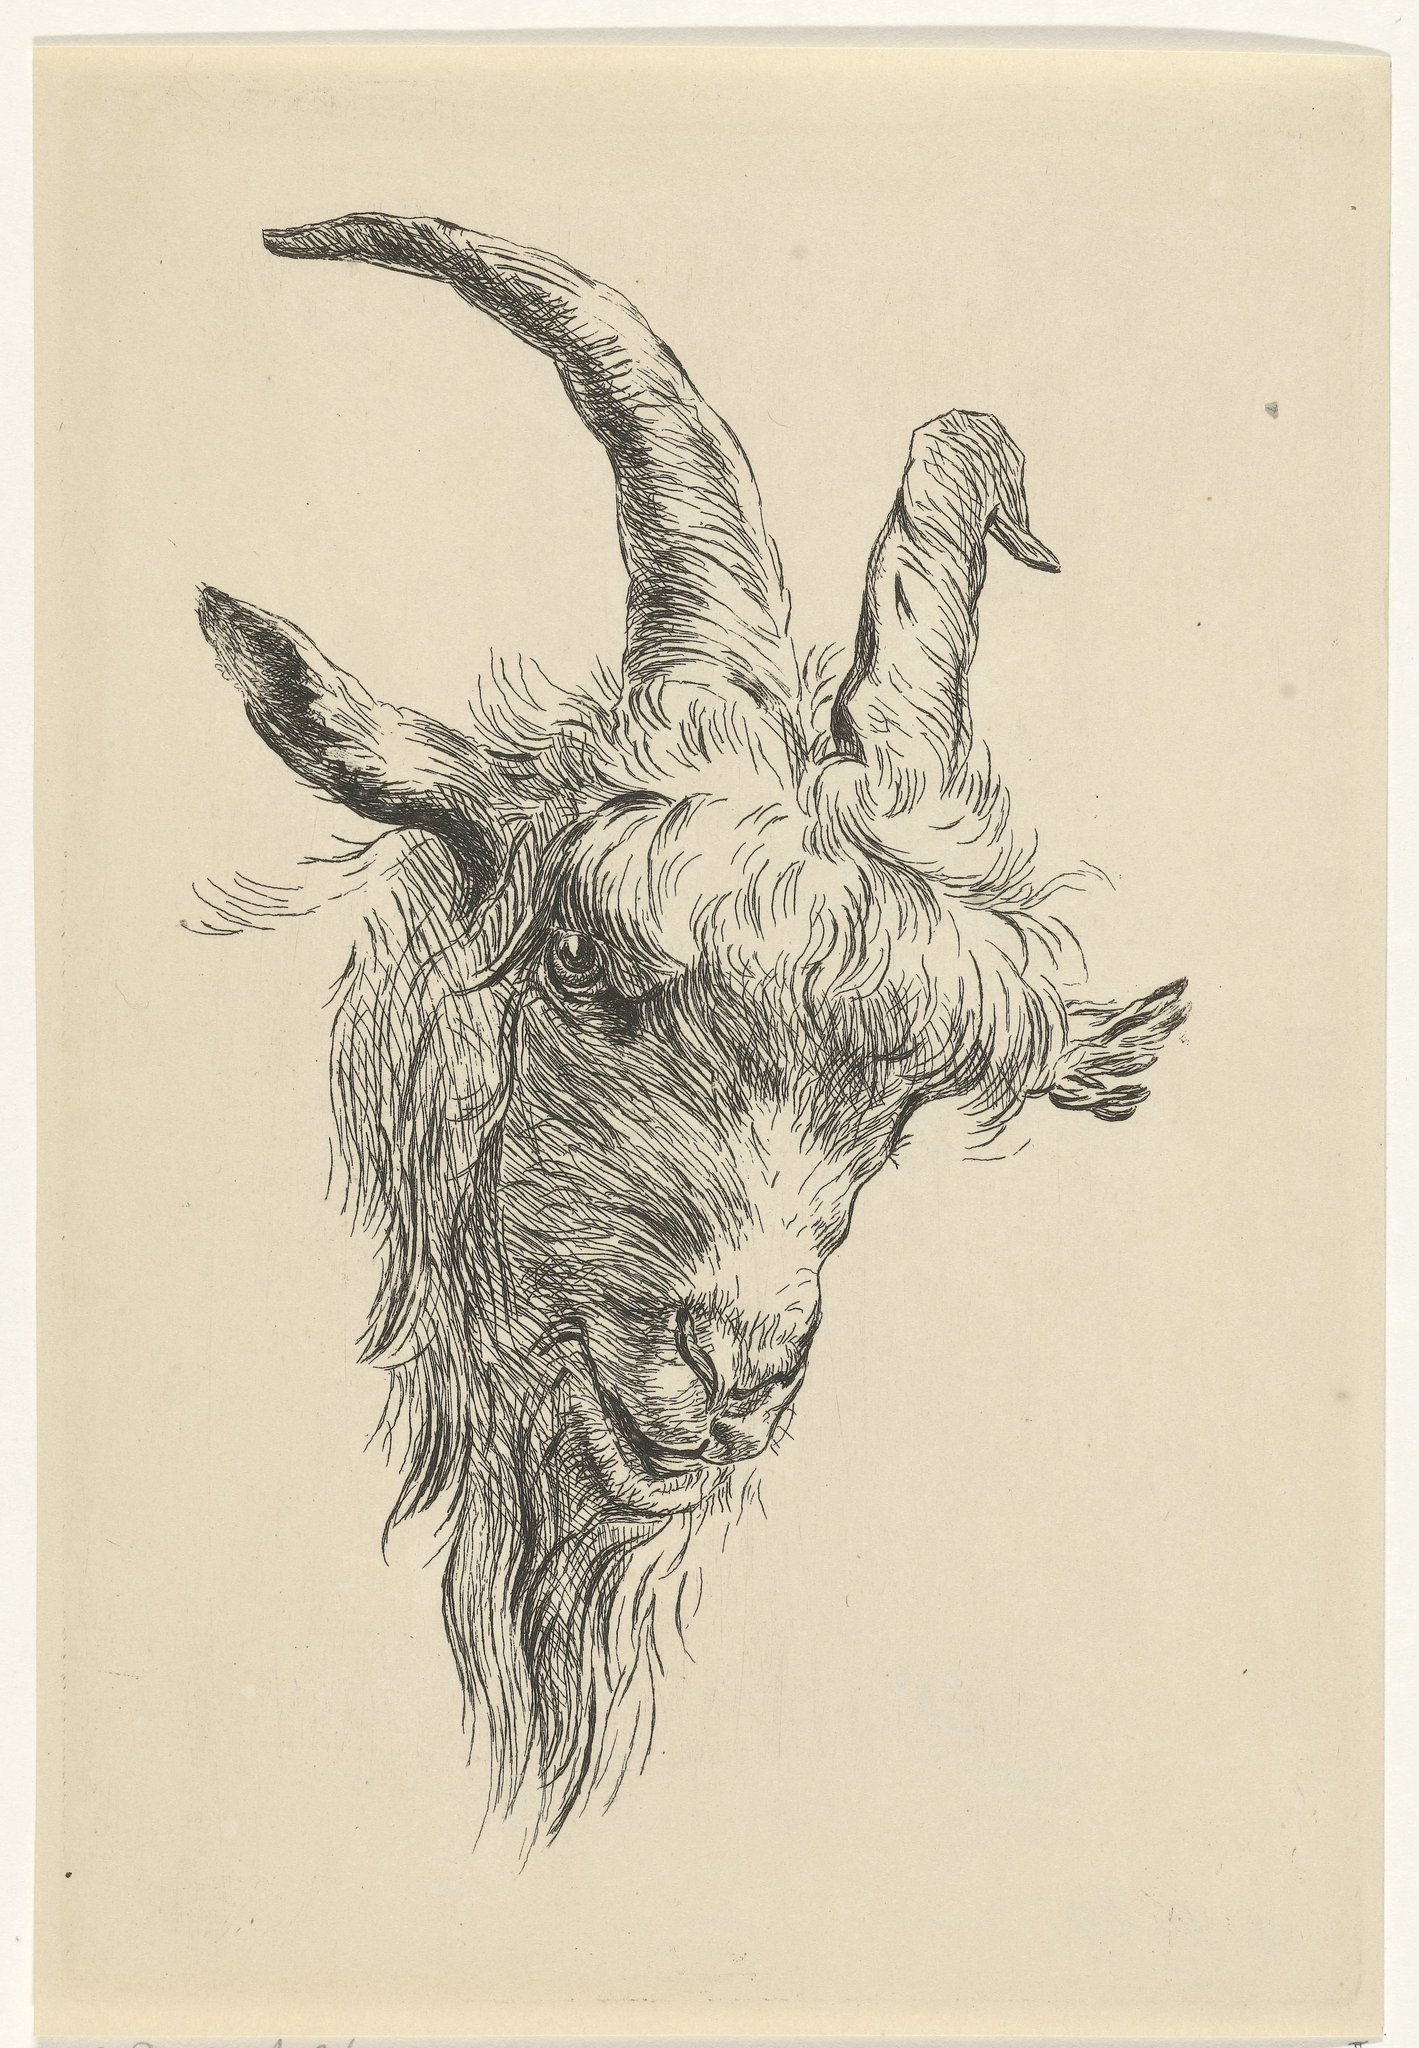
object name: print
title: Kop van een bok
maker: reinierus albertus ludovicus baron van isendoorn à blois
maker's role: print maker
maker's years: 1786-1856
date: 1796-1856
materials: paper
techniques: etching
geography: vaassen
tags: he-goat, billy-goat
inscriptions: collector's mark: Lugt 2228